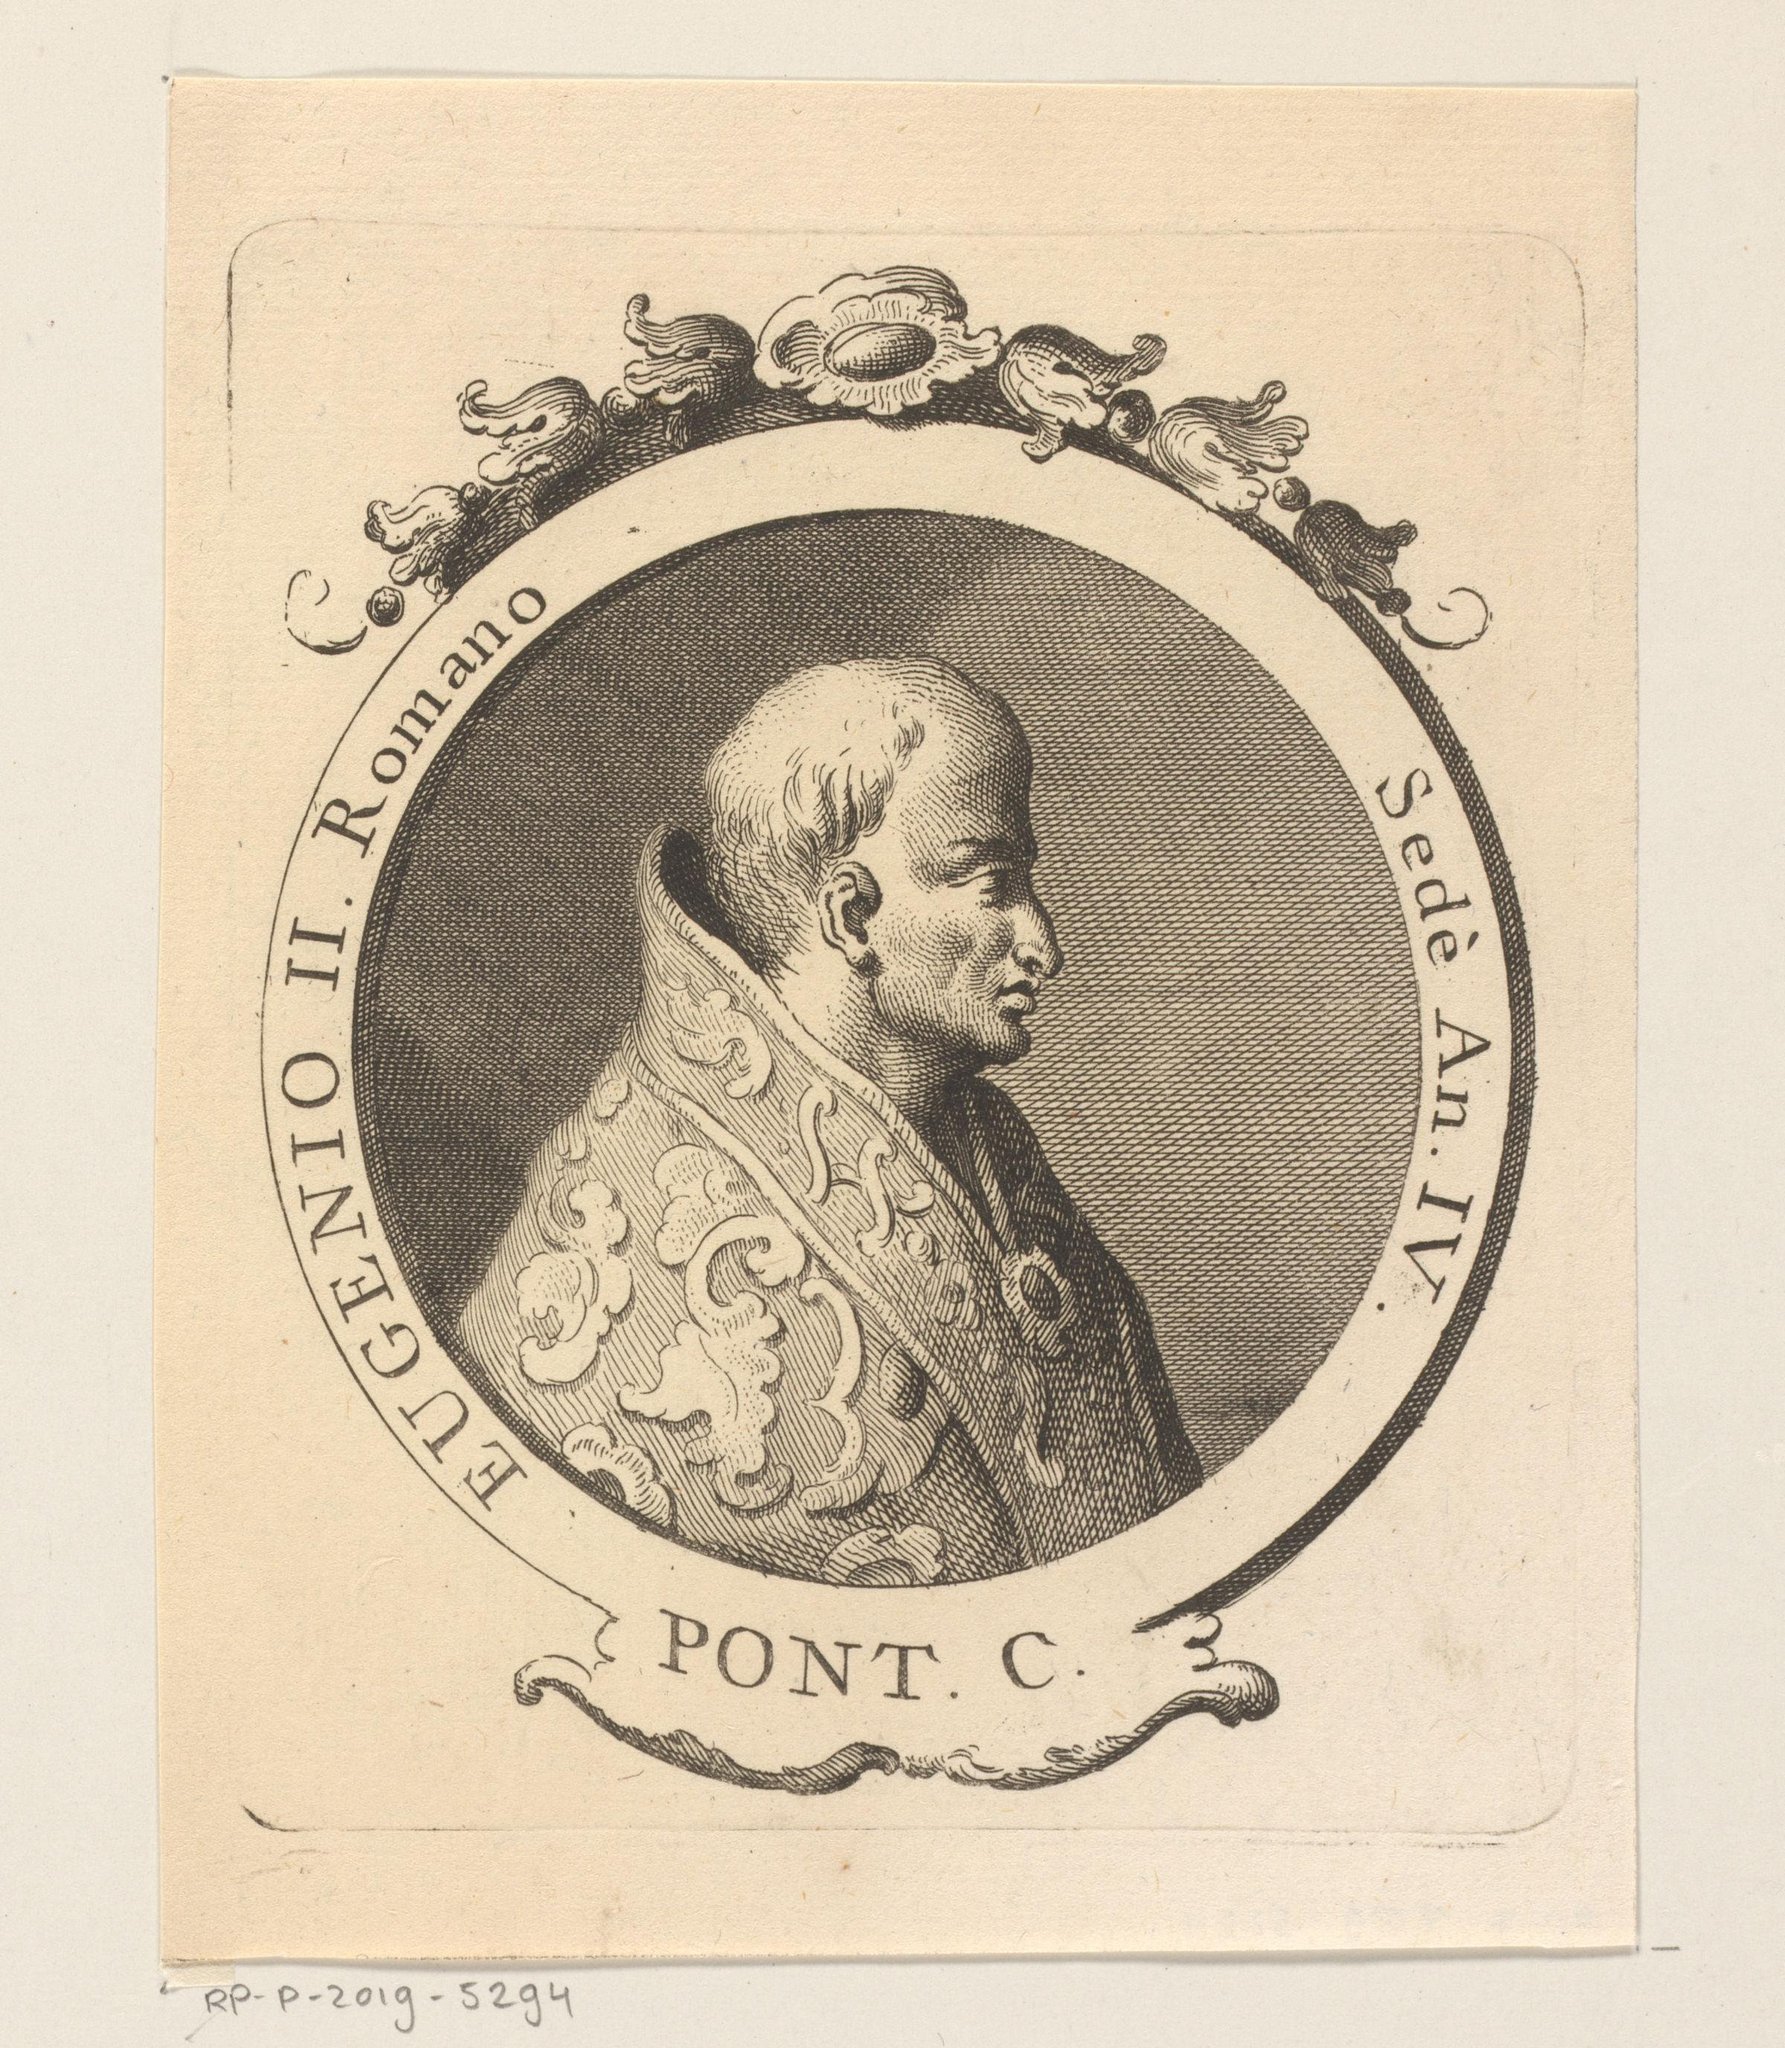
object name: book illustration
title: Portret van paus Eugenius II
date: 1775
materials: paper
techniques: etching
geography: venice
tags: rome, historical persons, pope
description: Prent uit: Effigies Romanorum pontificum a S. Petro ad Pium VI. feliciter regnantem (...). 2 dln. Venetië en Bassano del Grappa: Giuseppe Remondini, 1775.